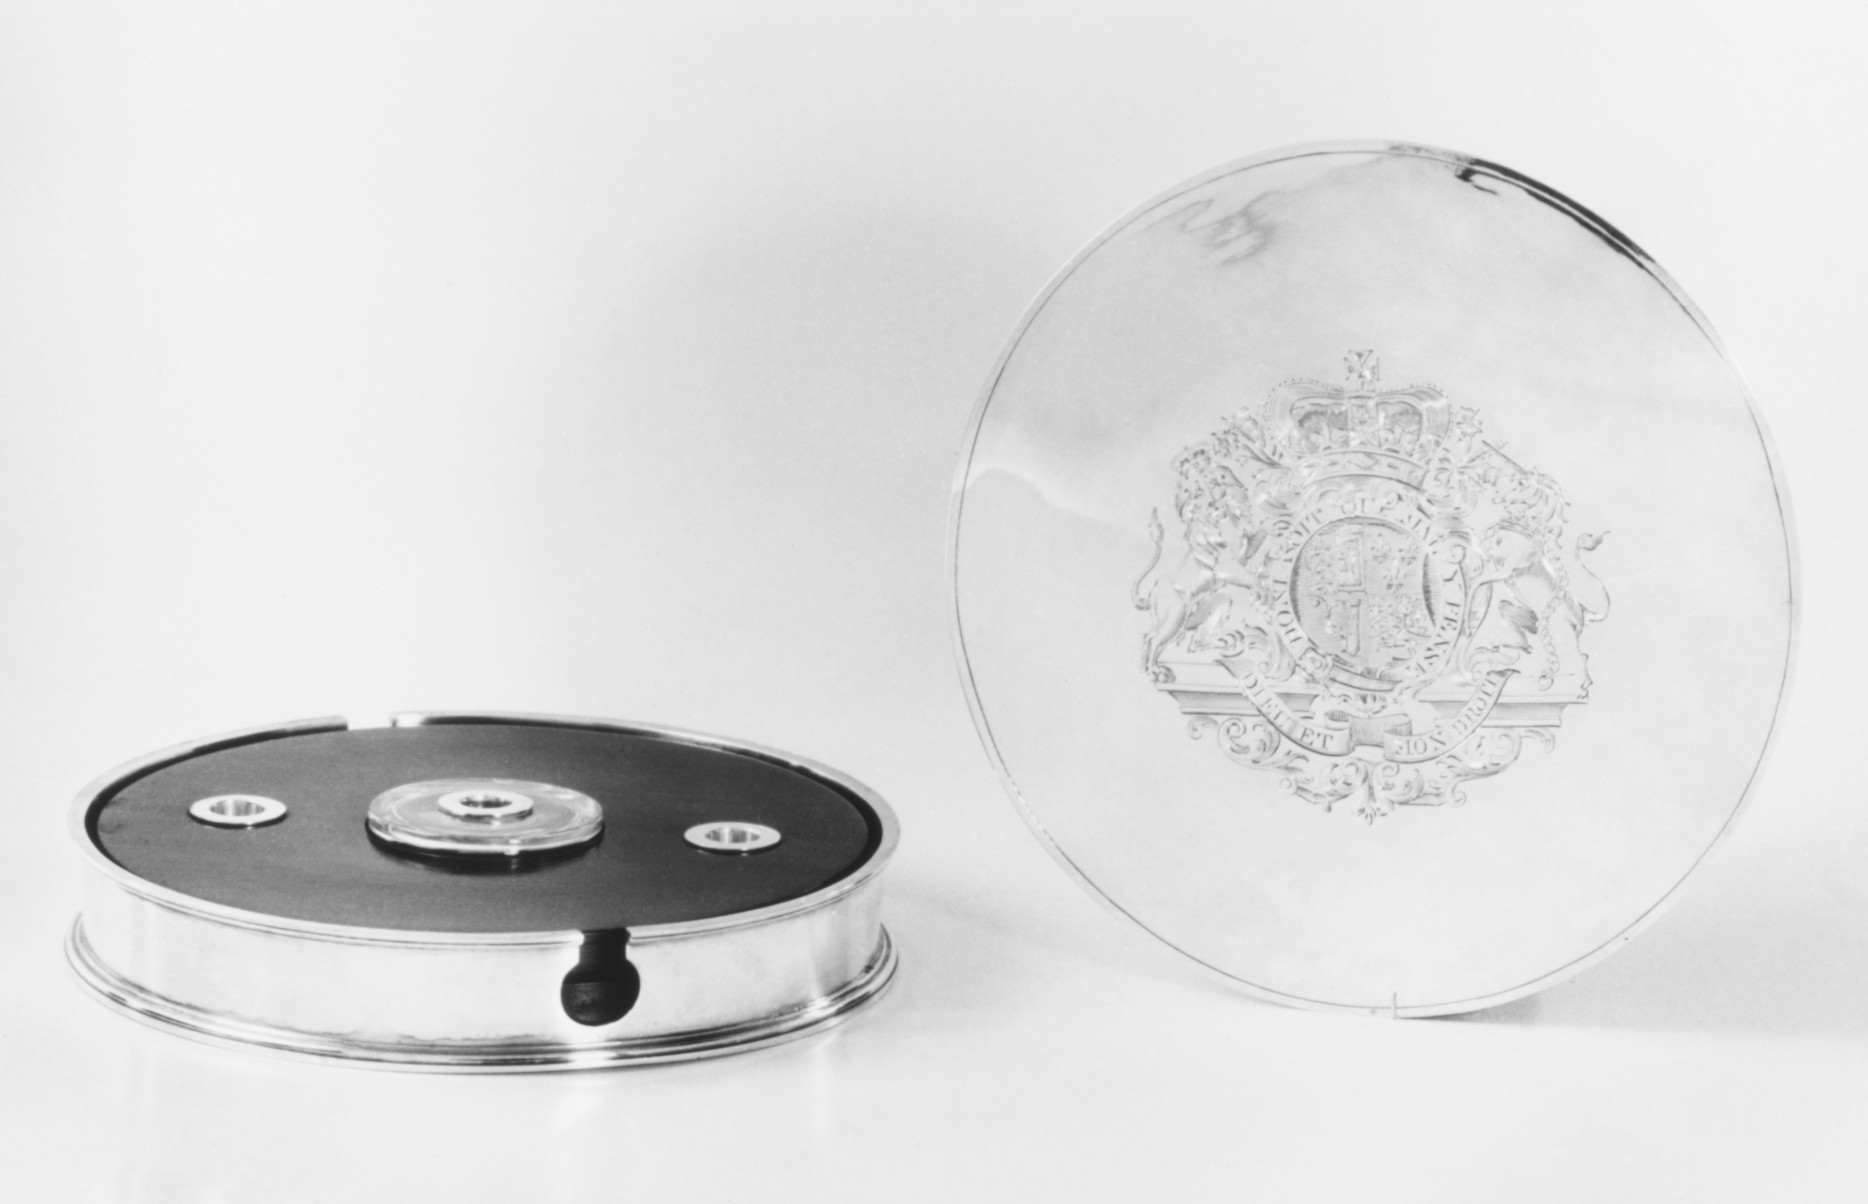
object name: seal box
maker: benjamin laver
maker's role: maker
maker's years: 1769-1800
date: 1783-1784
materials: glass, silver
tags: coat of arms